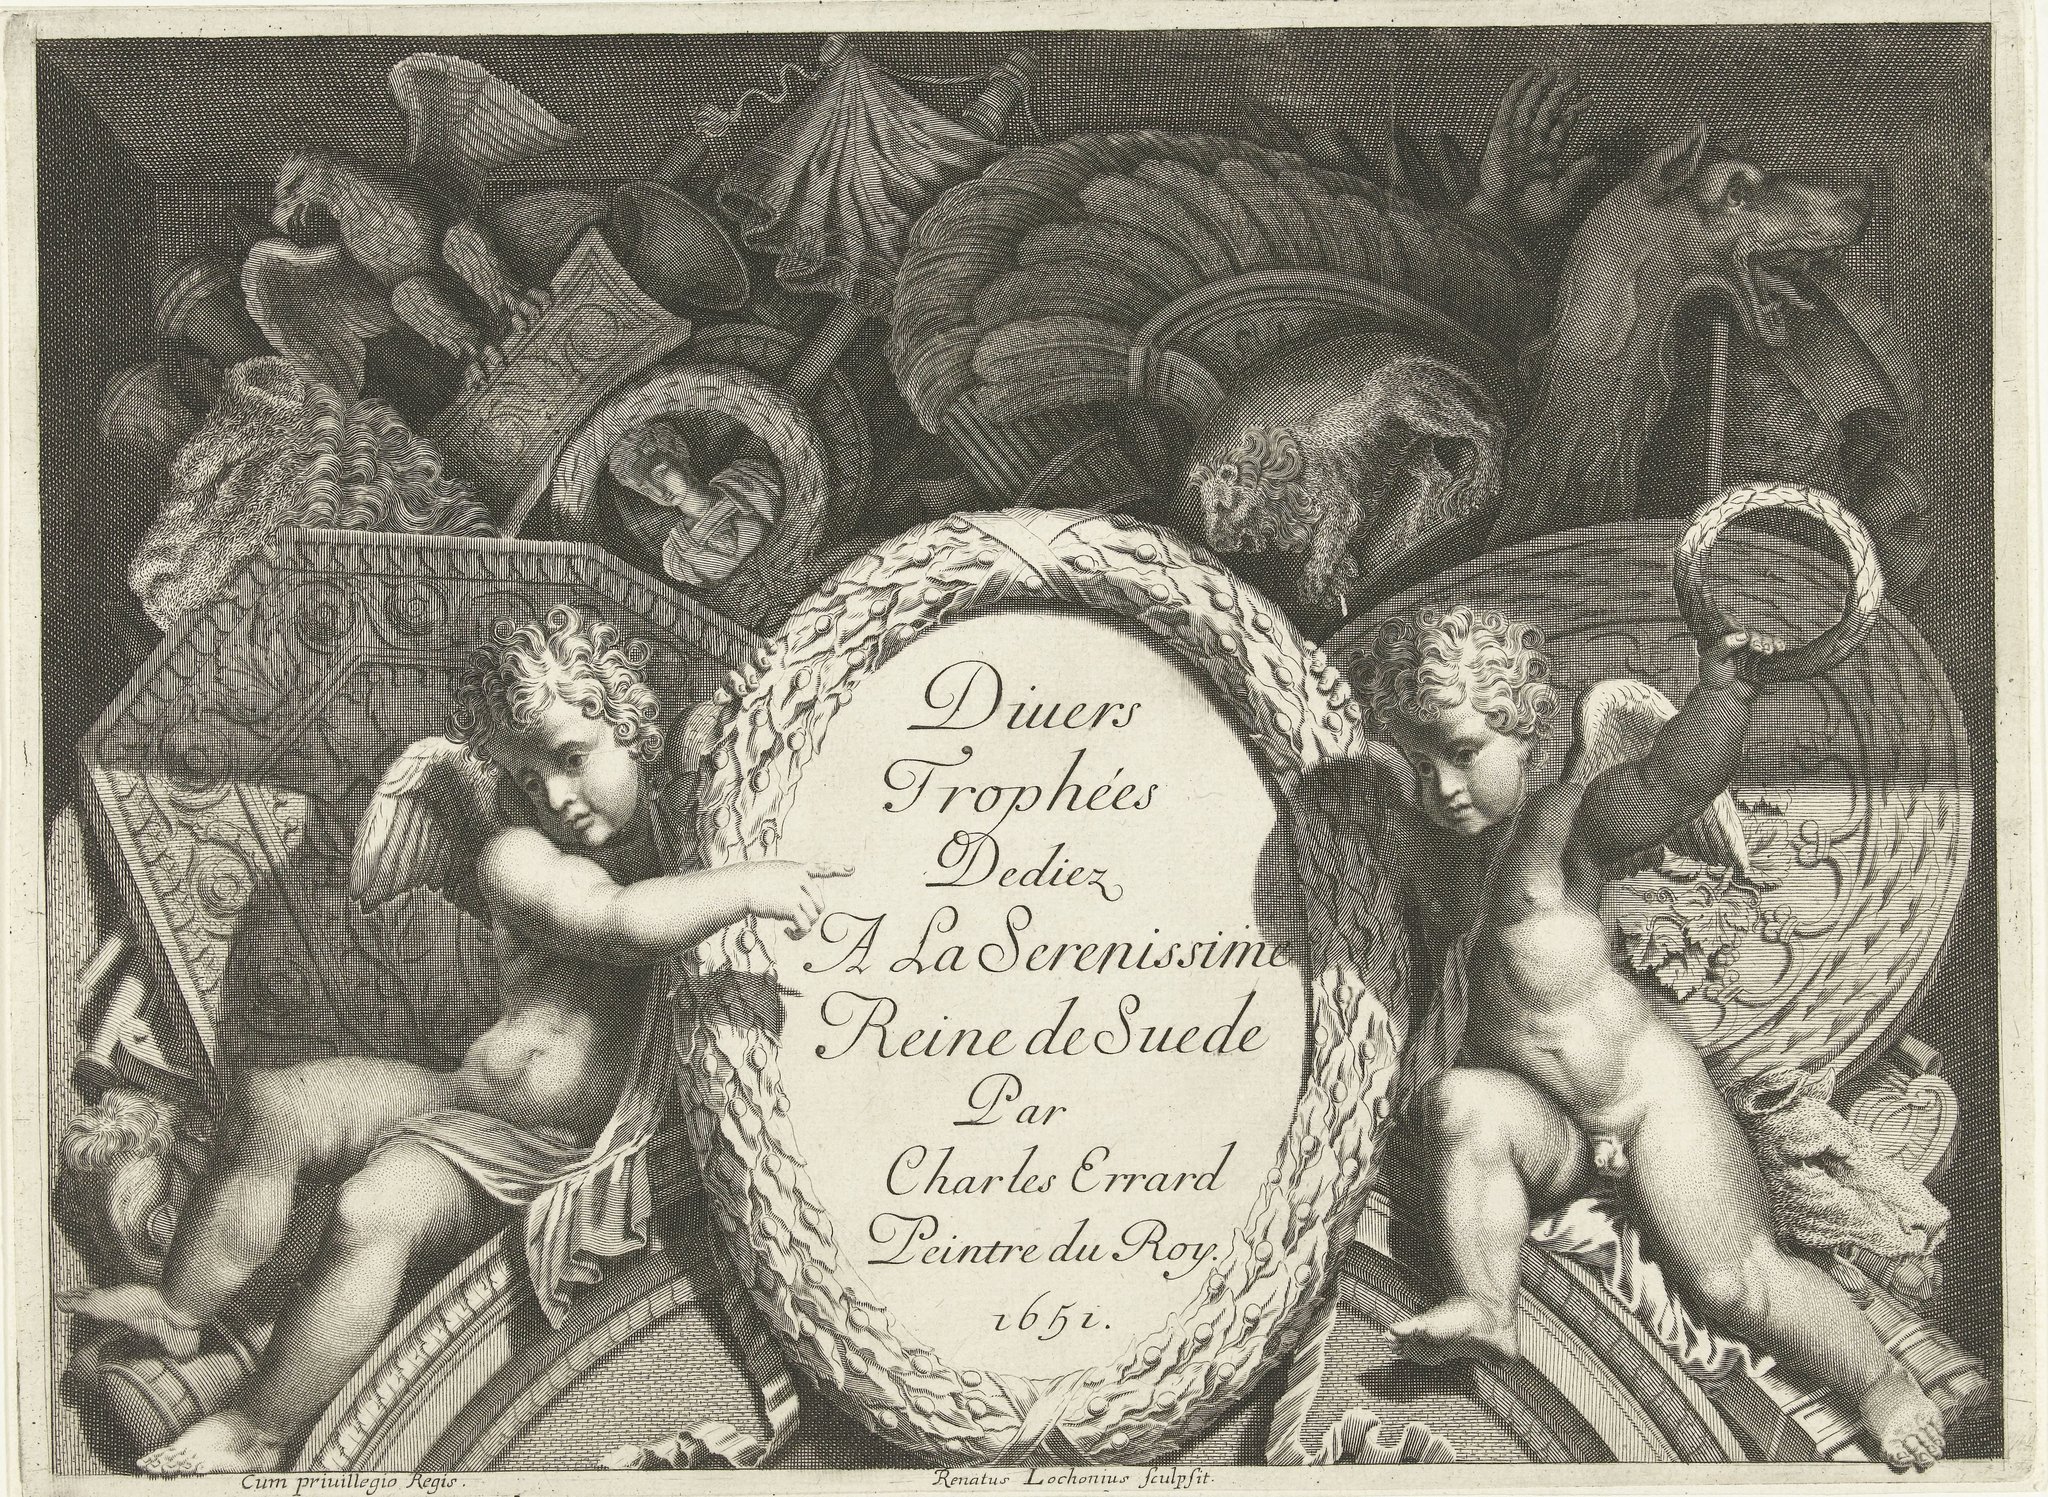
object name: ornament print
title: Titelblad: Divers Trophées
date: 1651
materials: paper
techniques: engraving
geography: paris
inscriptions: date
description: Voor een wapentrofee zitten twee putti naast een ovaal schild met de titel. Uit serie van titelblad en vijf bladen.